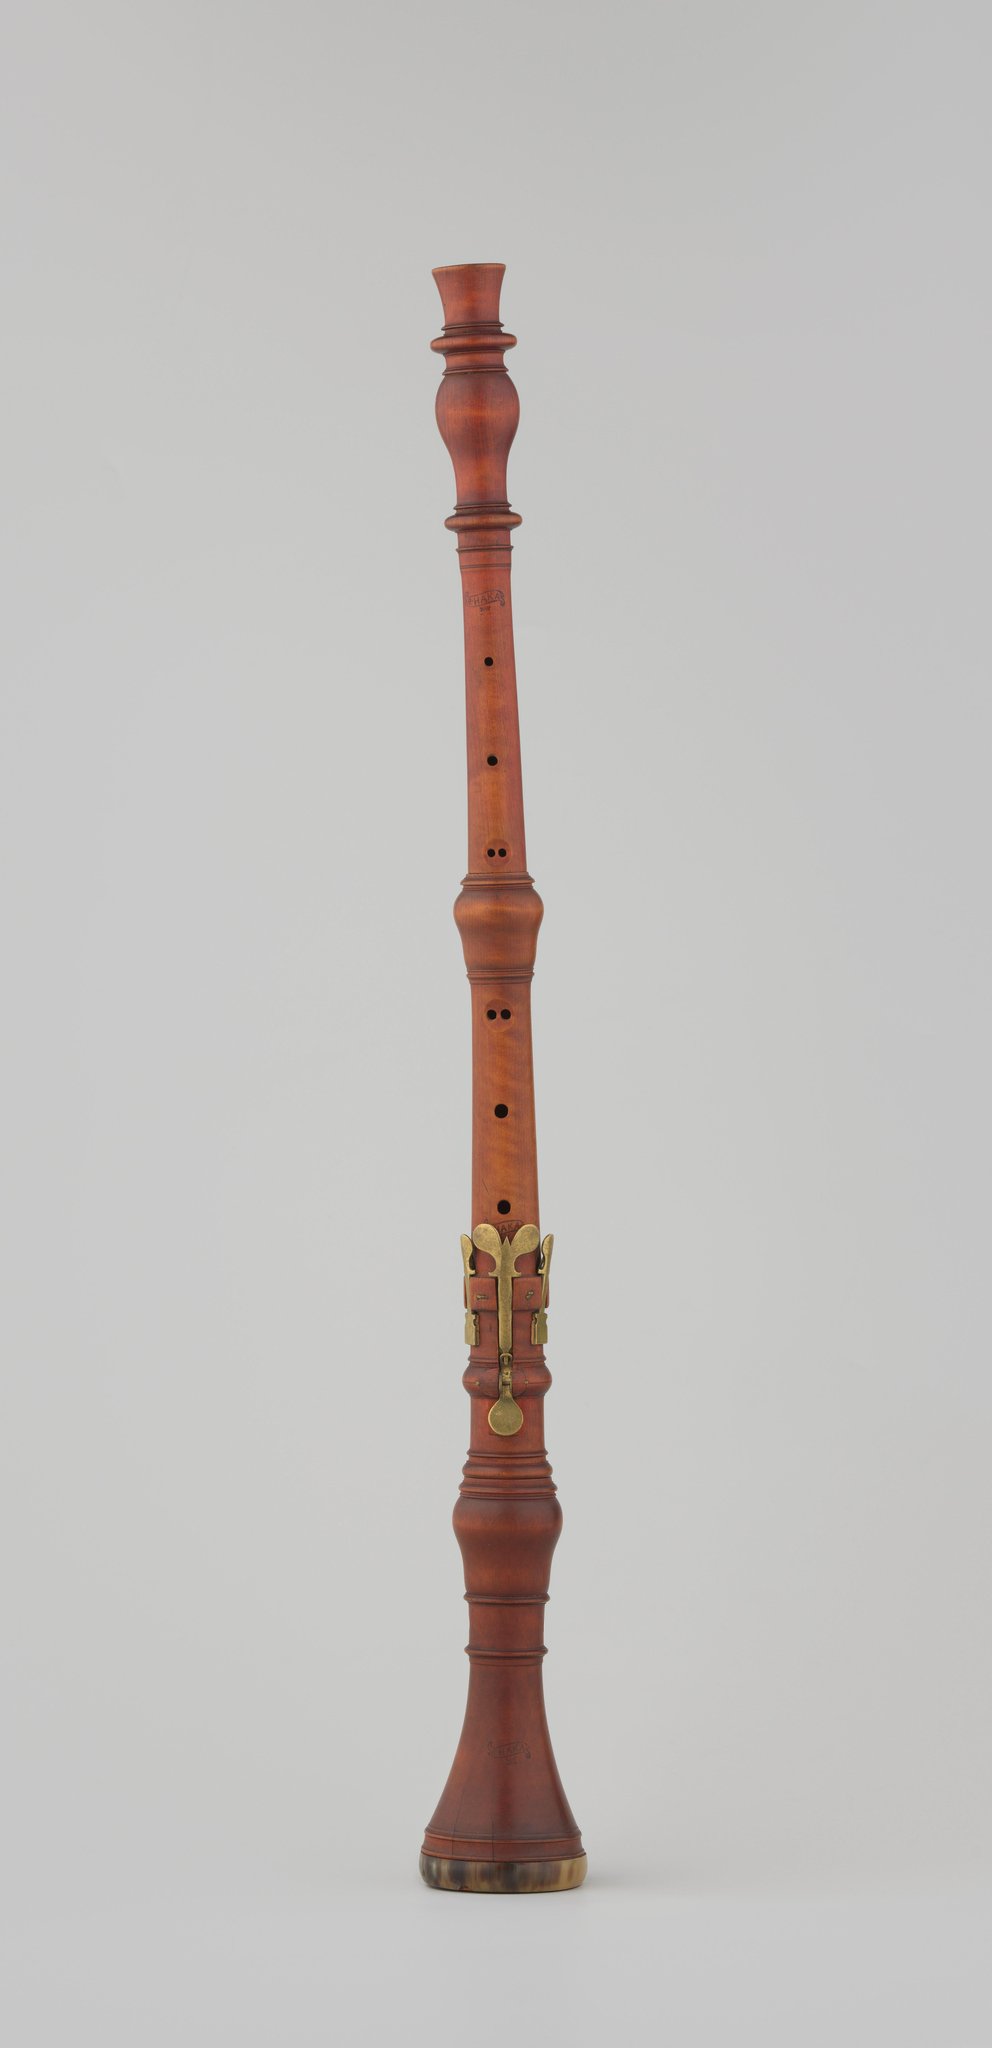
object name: wind instrument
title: Oboe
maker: richard haka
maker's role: musical instrument maker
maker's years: 1646-1705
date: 1690-1700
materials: wood, brass, copper, horn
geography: amsterdam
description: The oboe originated in 17th-century France. Dutch instrument makers immediately started making copies of these first French exemplars. In Amsterdam, Richard Haka started producing French hautbois (a name corrupted to oboe) already in 1680. Oboes were made of hardwoods – like boxwood, ebony, fruitwoods – and ivory. The keys were made of brass or, for fancier instruments, of silver.